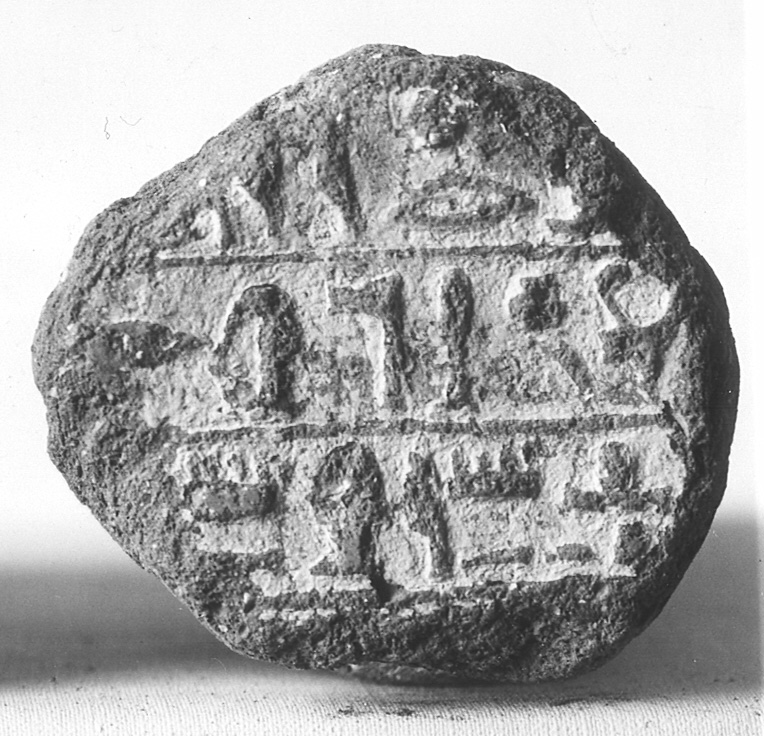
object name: cone, circular impression, amenhotep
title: Funerary Cone of Amenhotep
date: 1550-1352 BCE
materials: pottery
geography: egypt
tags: hieroglyphs